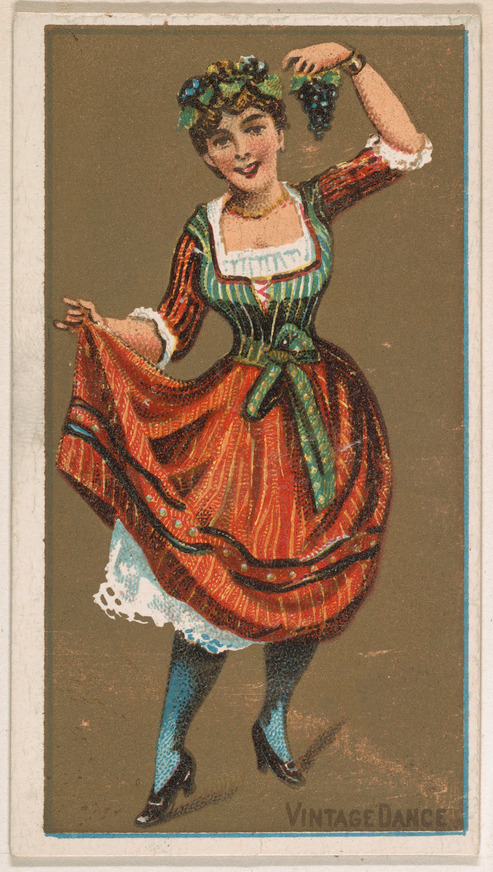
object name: print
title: Vintage Dance, from National Dances (N225, Type 1) issued by Kinney Bros.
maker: kinney brothers tobacco company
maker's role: publisher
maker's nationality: american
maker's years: 1869-2011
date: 1889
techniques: color lithograph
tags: dance,grapes,women,dancers